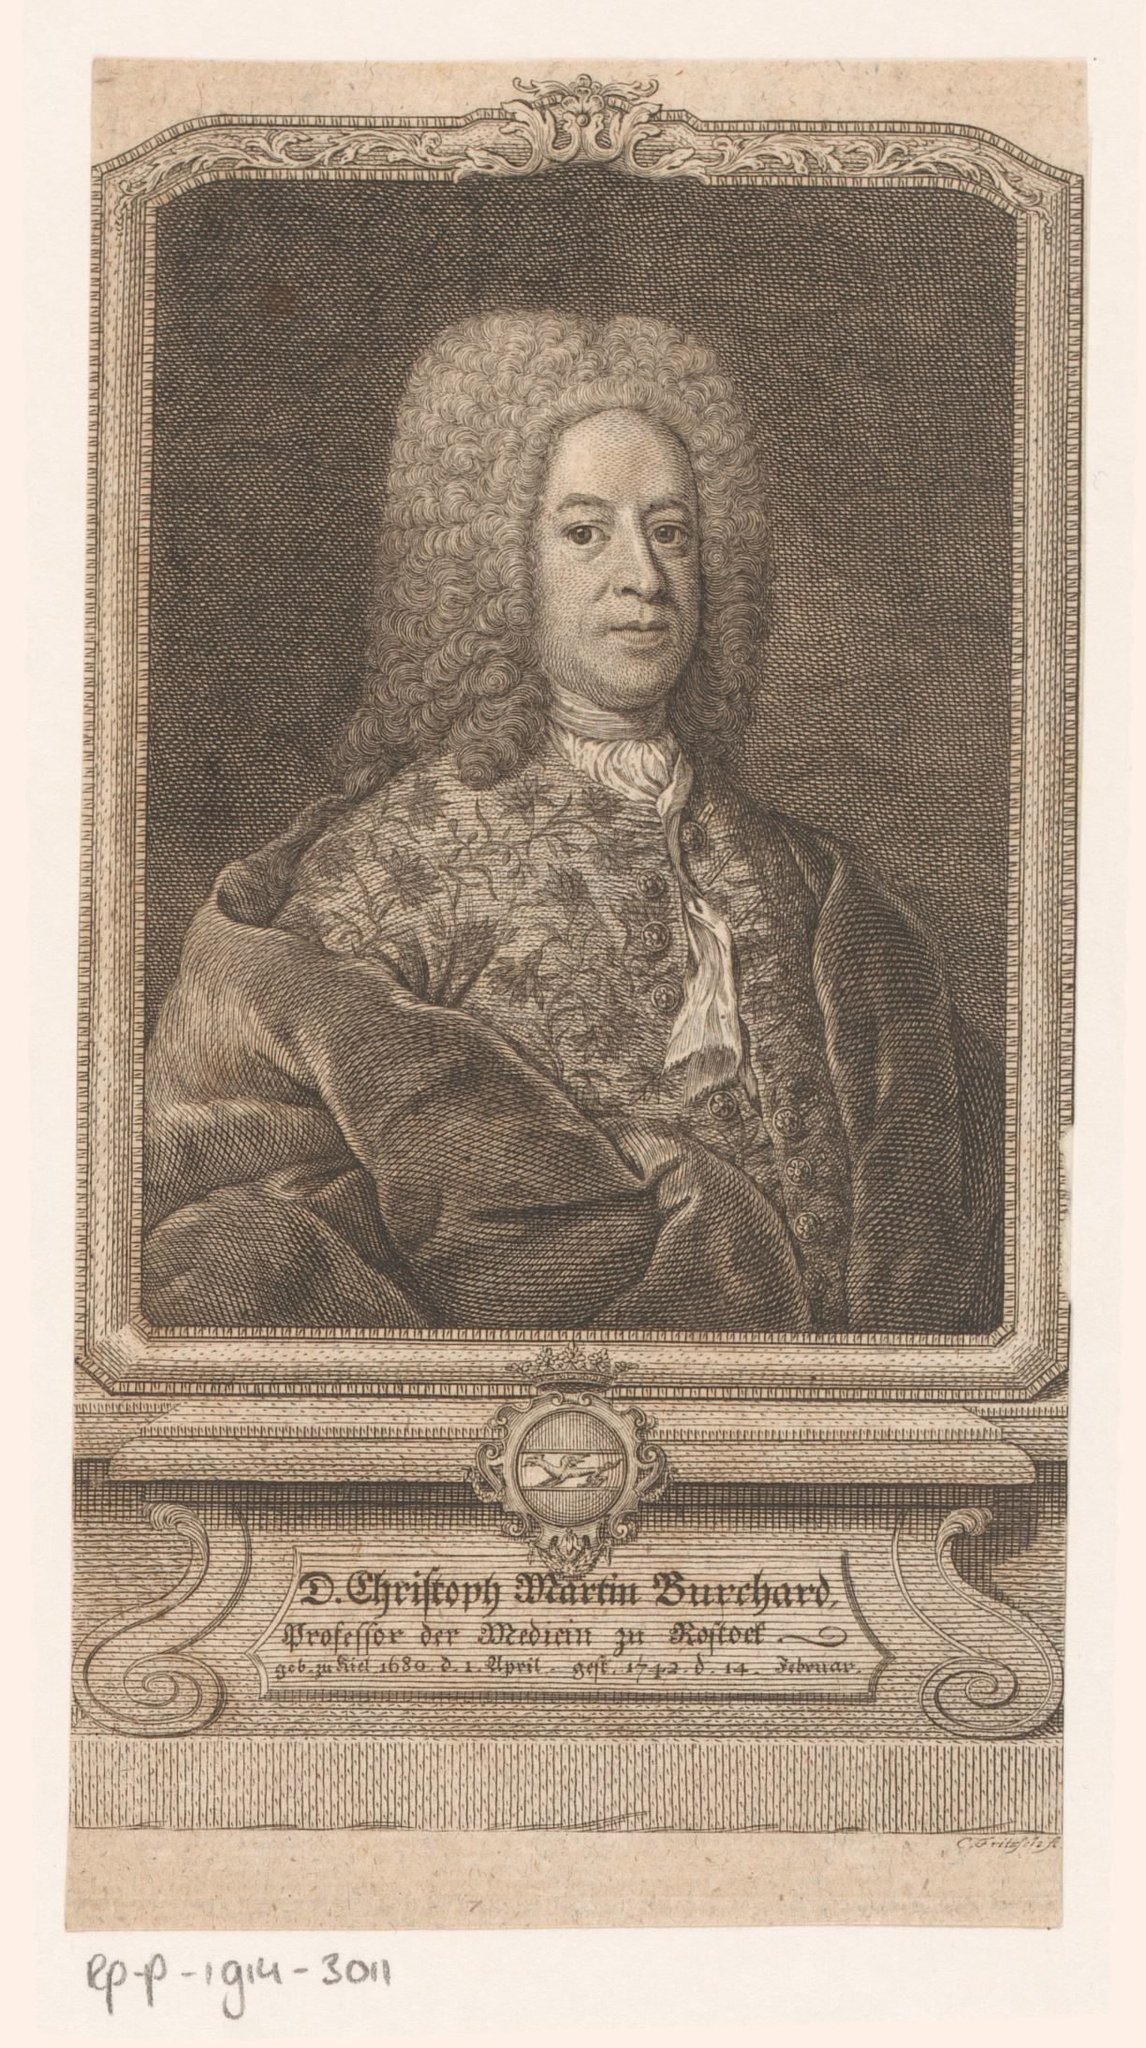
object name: print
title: Portret van Christoph Martin Burchard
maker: christian fritzsch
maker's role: print maker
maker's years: 1695-1769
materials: paper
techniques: engraving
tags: historical persons, armorial bearing, heraldry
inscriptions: collector's mark: Lugt 2228